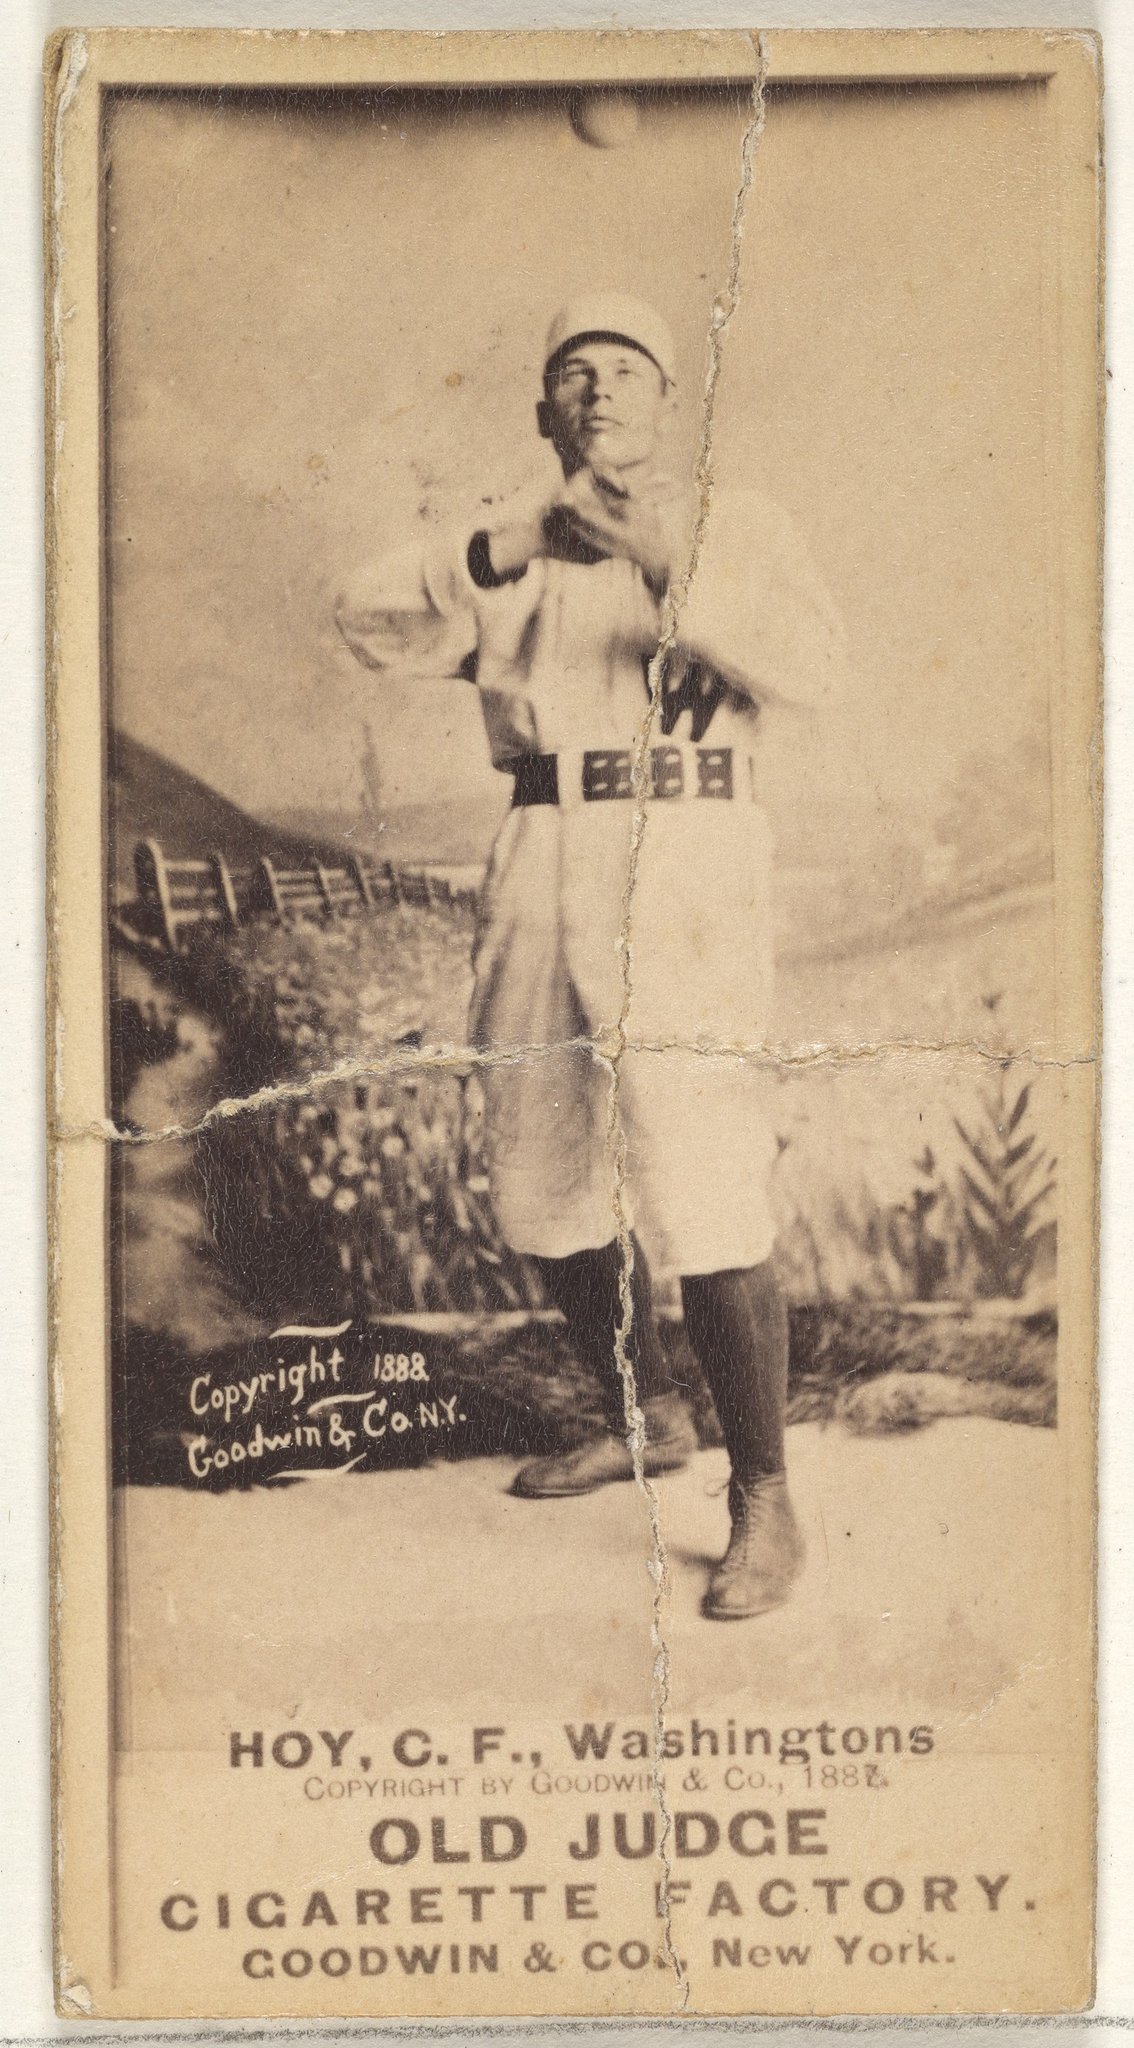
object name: baseball card, photograph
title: William Ellsworth "Dummy" Hoy, Center Field, Washington Nationals, from the Old Judge series (N172) for Old Judge Cigarettes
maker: goodwin & company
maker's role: publisher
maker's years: 1850-1950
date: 1888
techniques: albumen silver print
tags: men,portraits,baseball,athletes